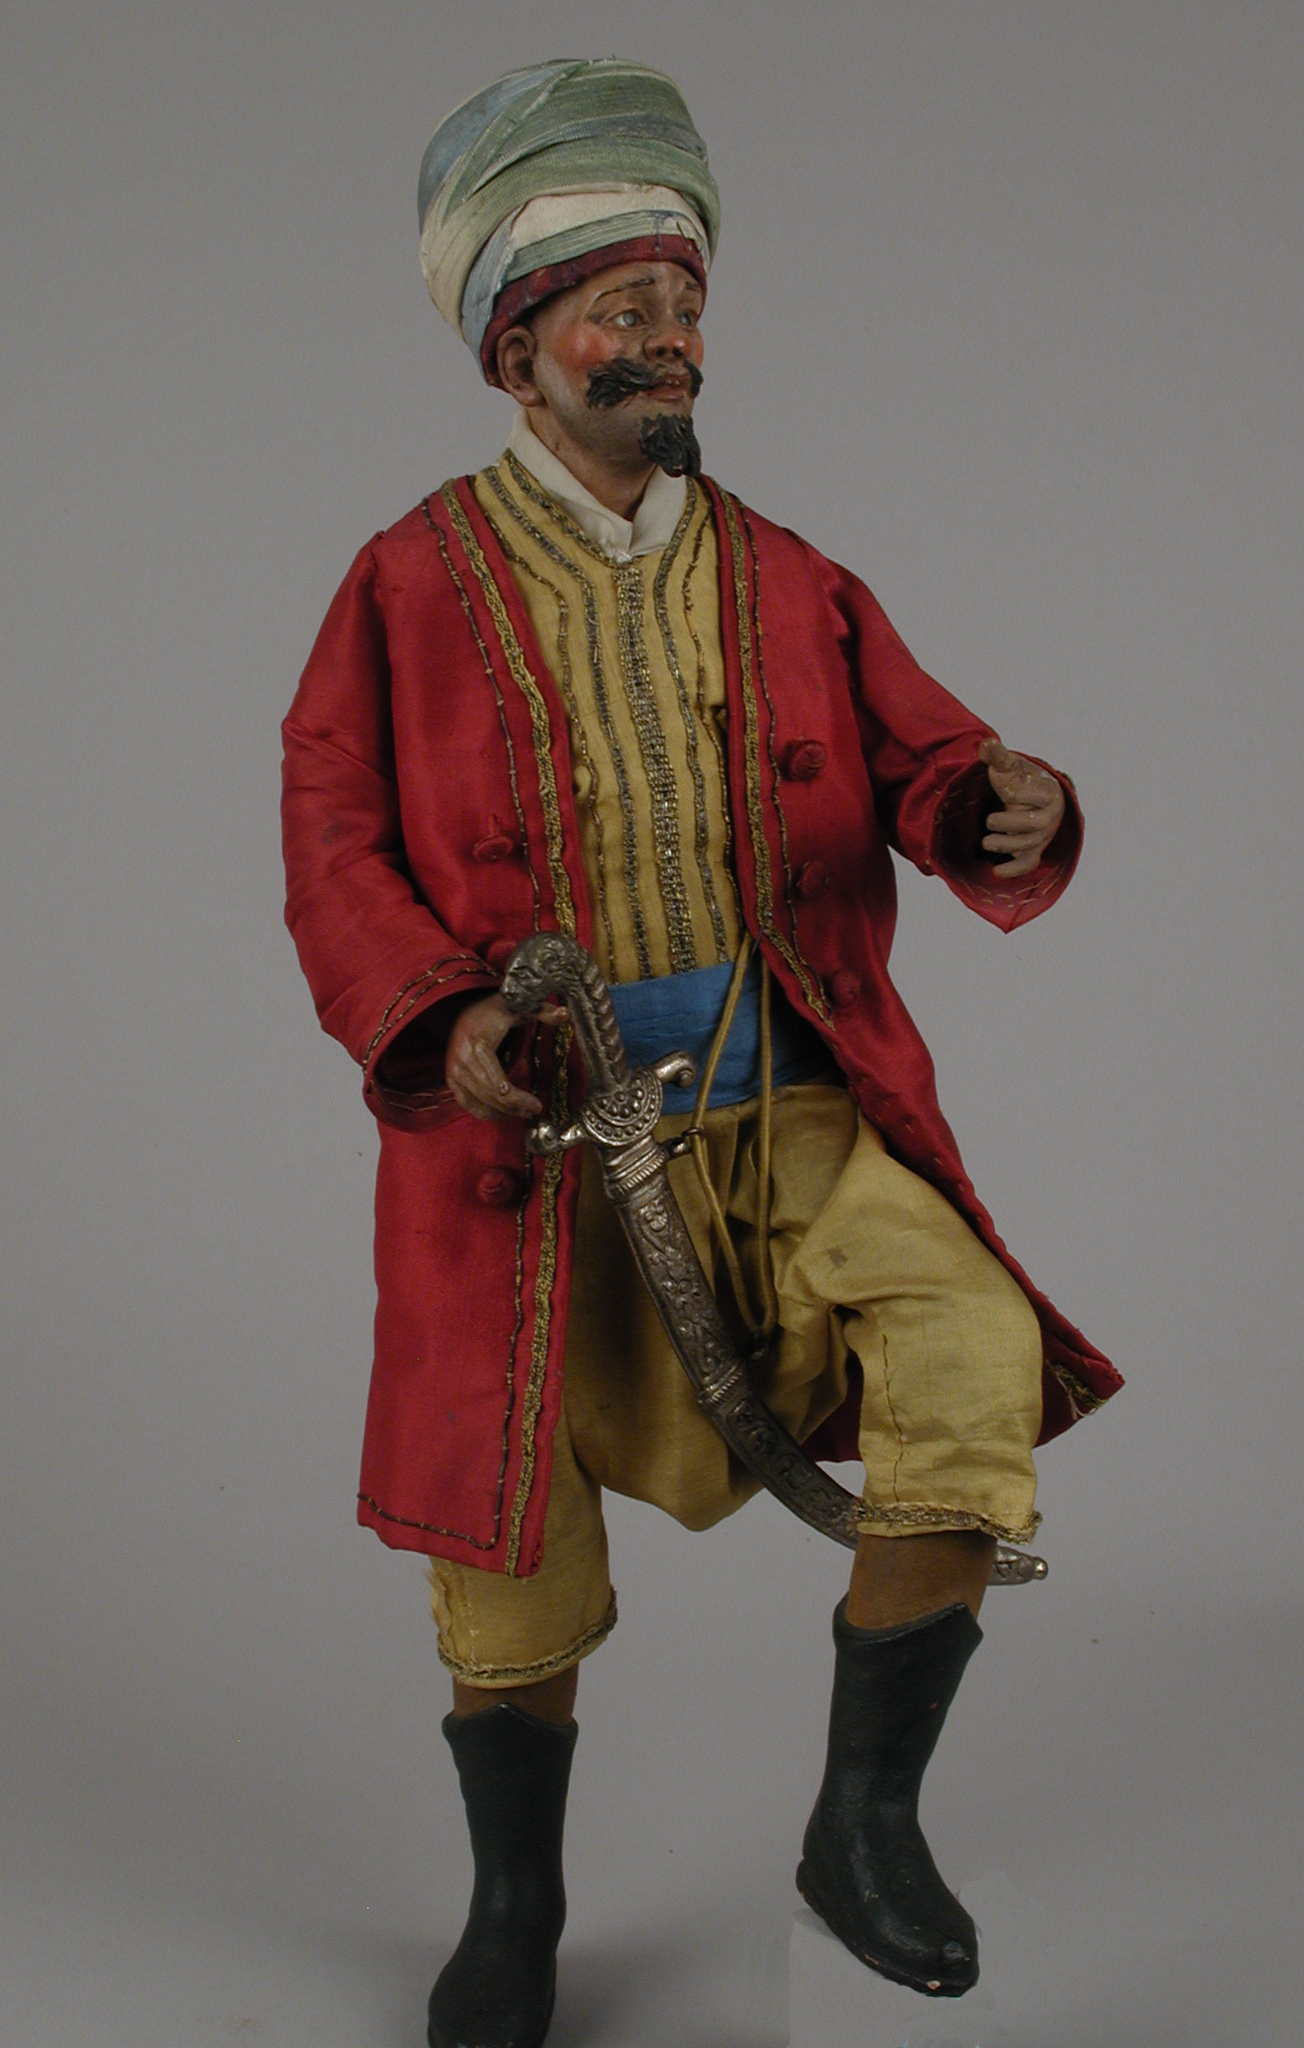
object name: crèche figure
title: Man with turban hat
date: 1701-1900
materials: terracotta, fiber, metal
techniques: polychrome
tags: swords,men